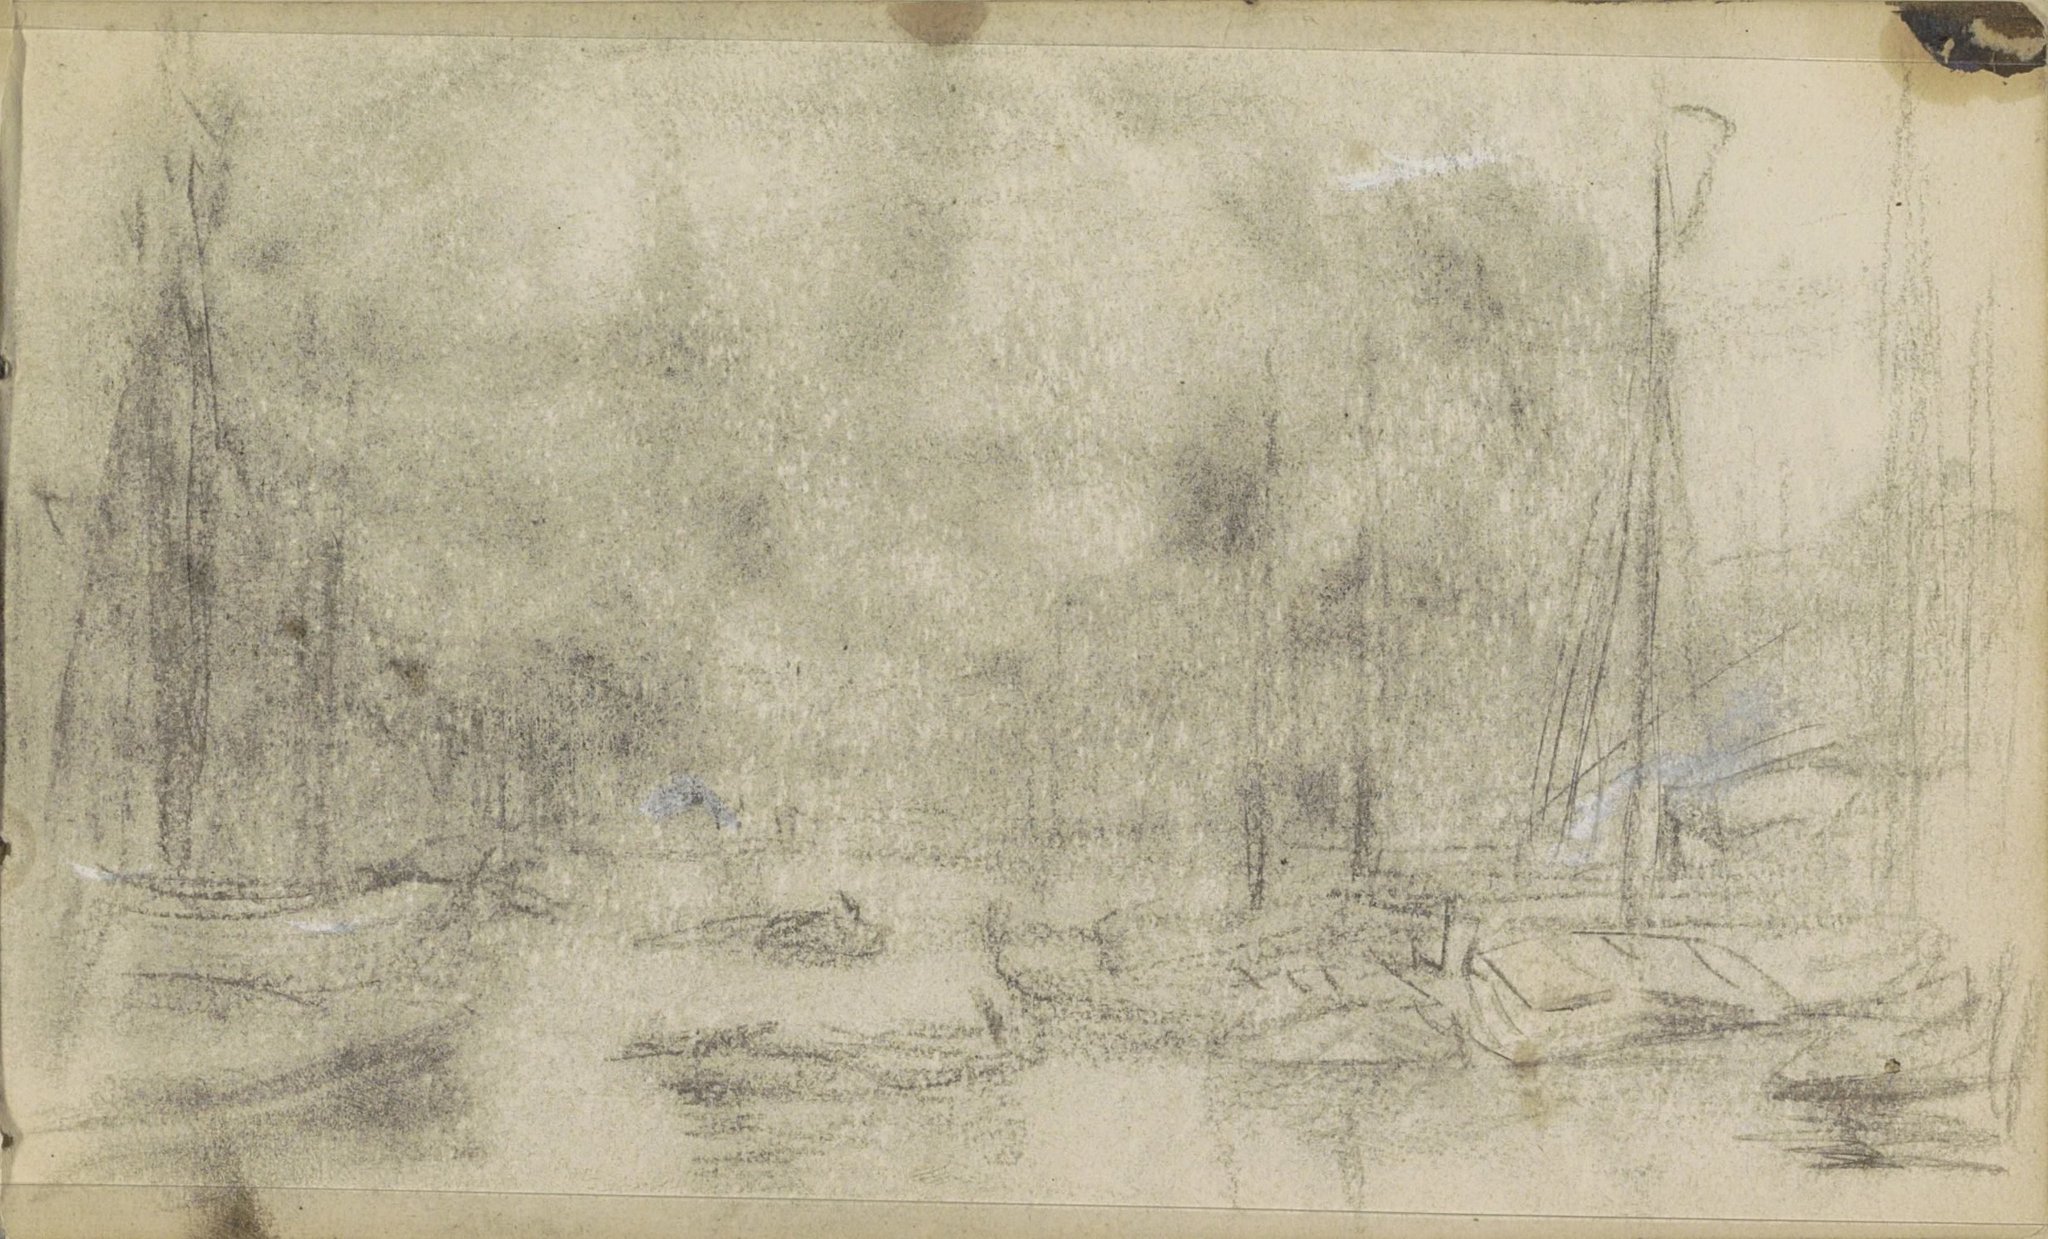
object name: sketchbook leaf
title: Aangemeerde zeilboten, vermoedelijk bij een haven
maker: jozef israëls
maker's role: draughtsman, painter, print maker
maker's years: 1824-1911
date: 1834-1911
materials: chalk, paper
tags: sailing-ship, sailing-boat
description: Blad 15 recto uit een schetsboek met 42 bladen.